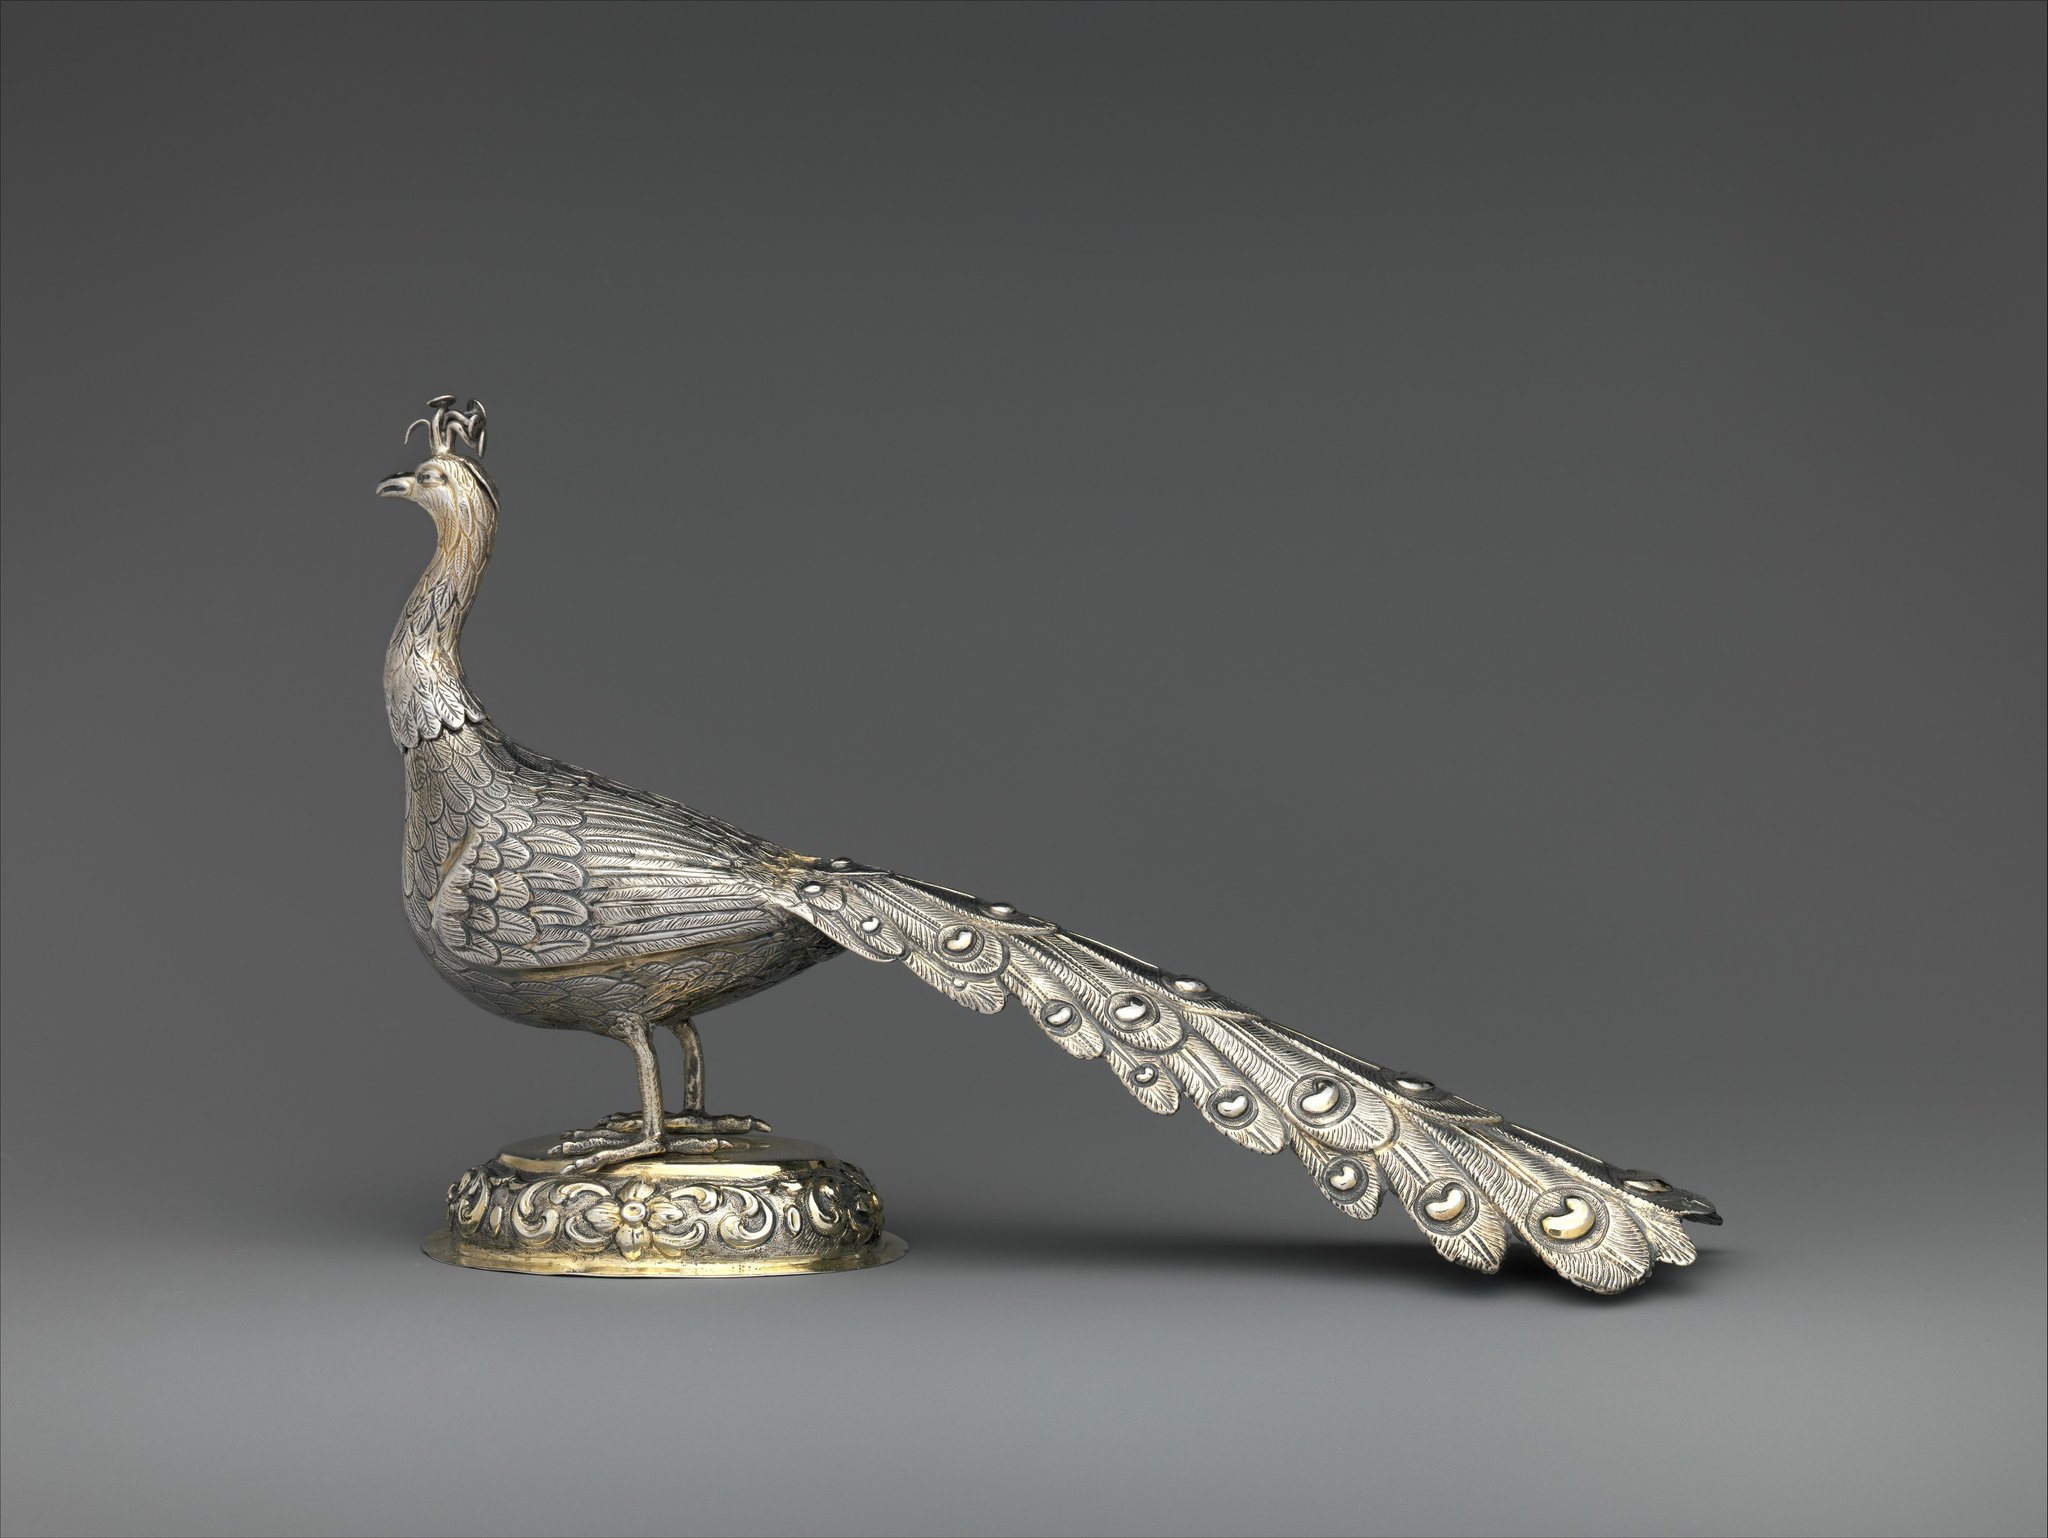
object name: figure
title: Table decoration in the form of a peacock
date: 1787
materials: silver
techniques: gilding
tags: peacocks